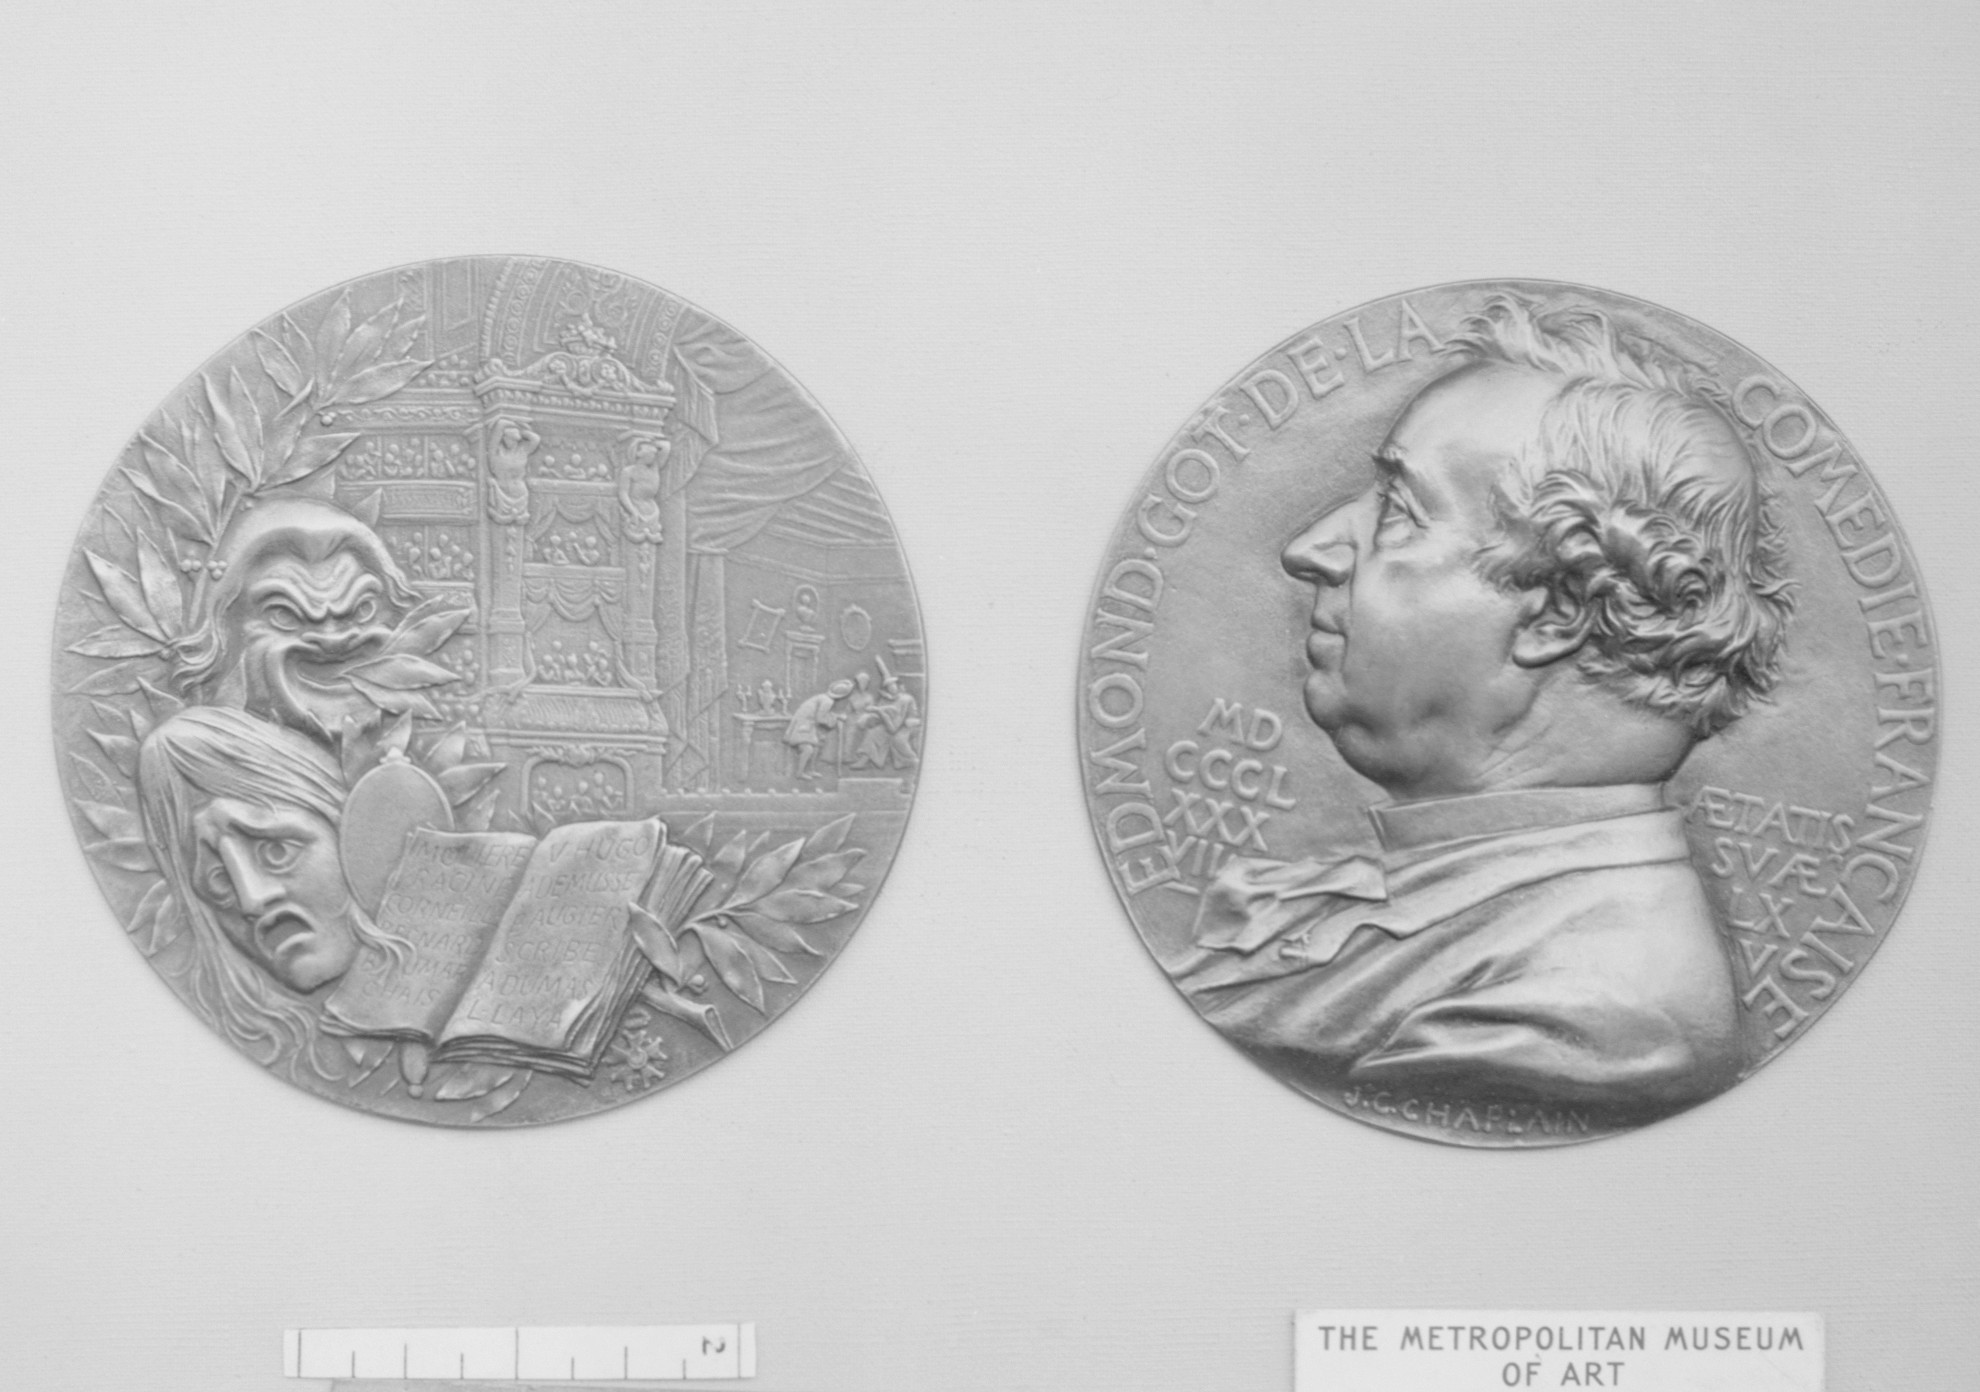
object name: medallion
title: François Jules Edmond Got (1822–1901), French Actor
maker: jules-clément chaplain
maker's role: artist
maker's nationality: french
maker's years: 1839-1909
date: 1887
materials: bronze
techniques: casting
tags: masks,men,actors